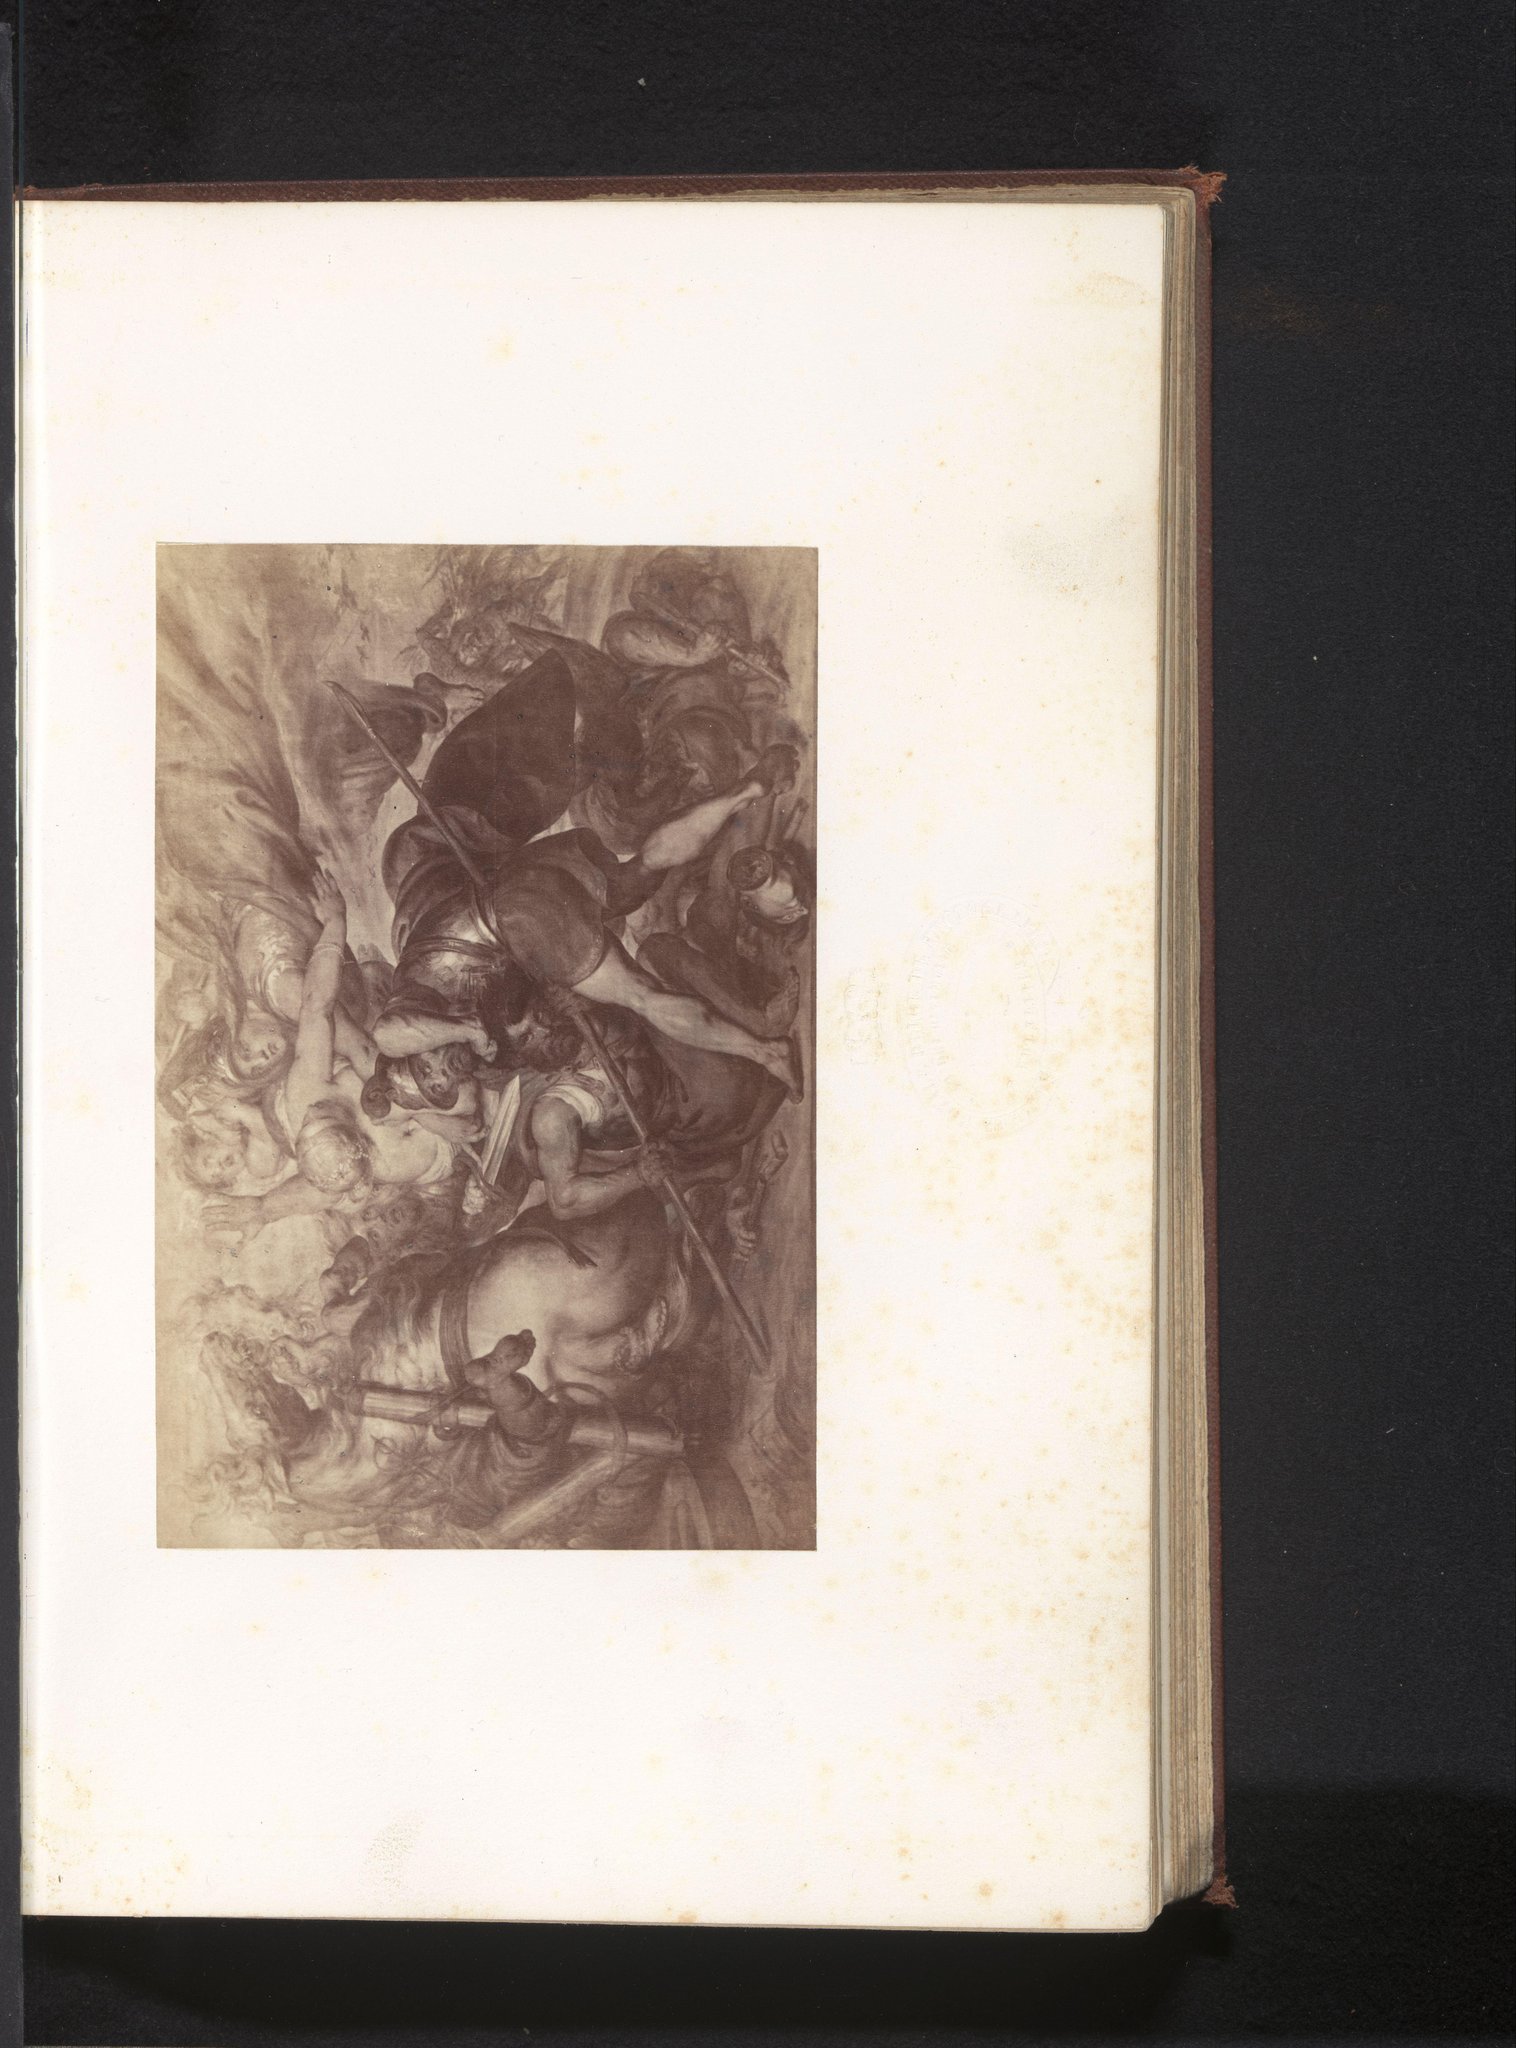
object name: reproduction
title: Fotoreproductie van De homerische worsteling door Antoine Wiertz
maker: edmond fierlants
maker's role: fotograaf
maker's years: 1819-1869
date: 1863-1868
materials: photographic support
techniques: albumen print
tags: fighting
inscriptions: check stamp: ‘SOCIÉTÉ ROYALE BELGE DE PHOTOGRAPHIE/ 69, RUE KEYENVELD/ BRUXELLES’